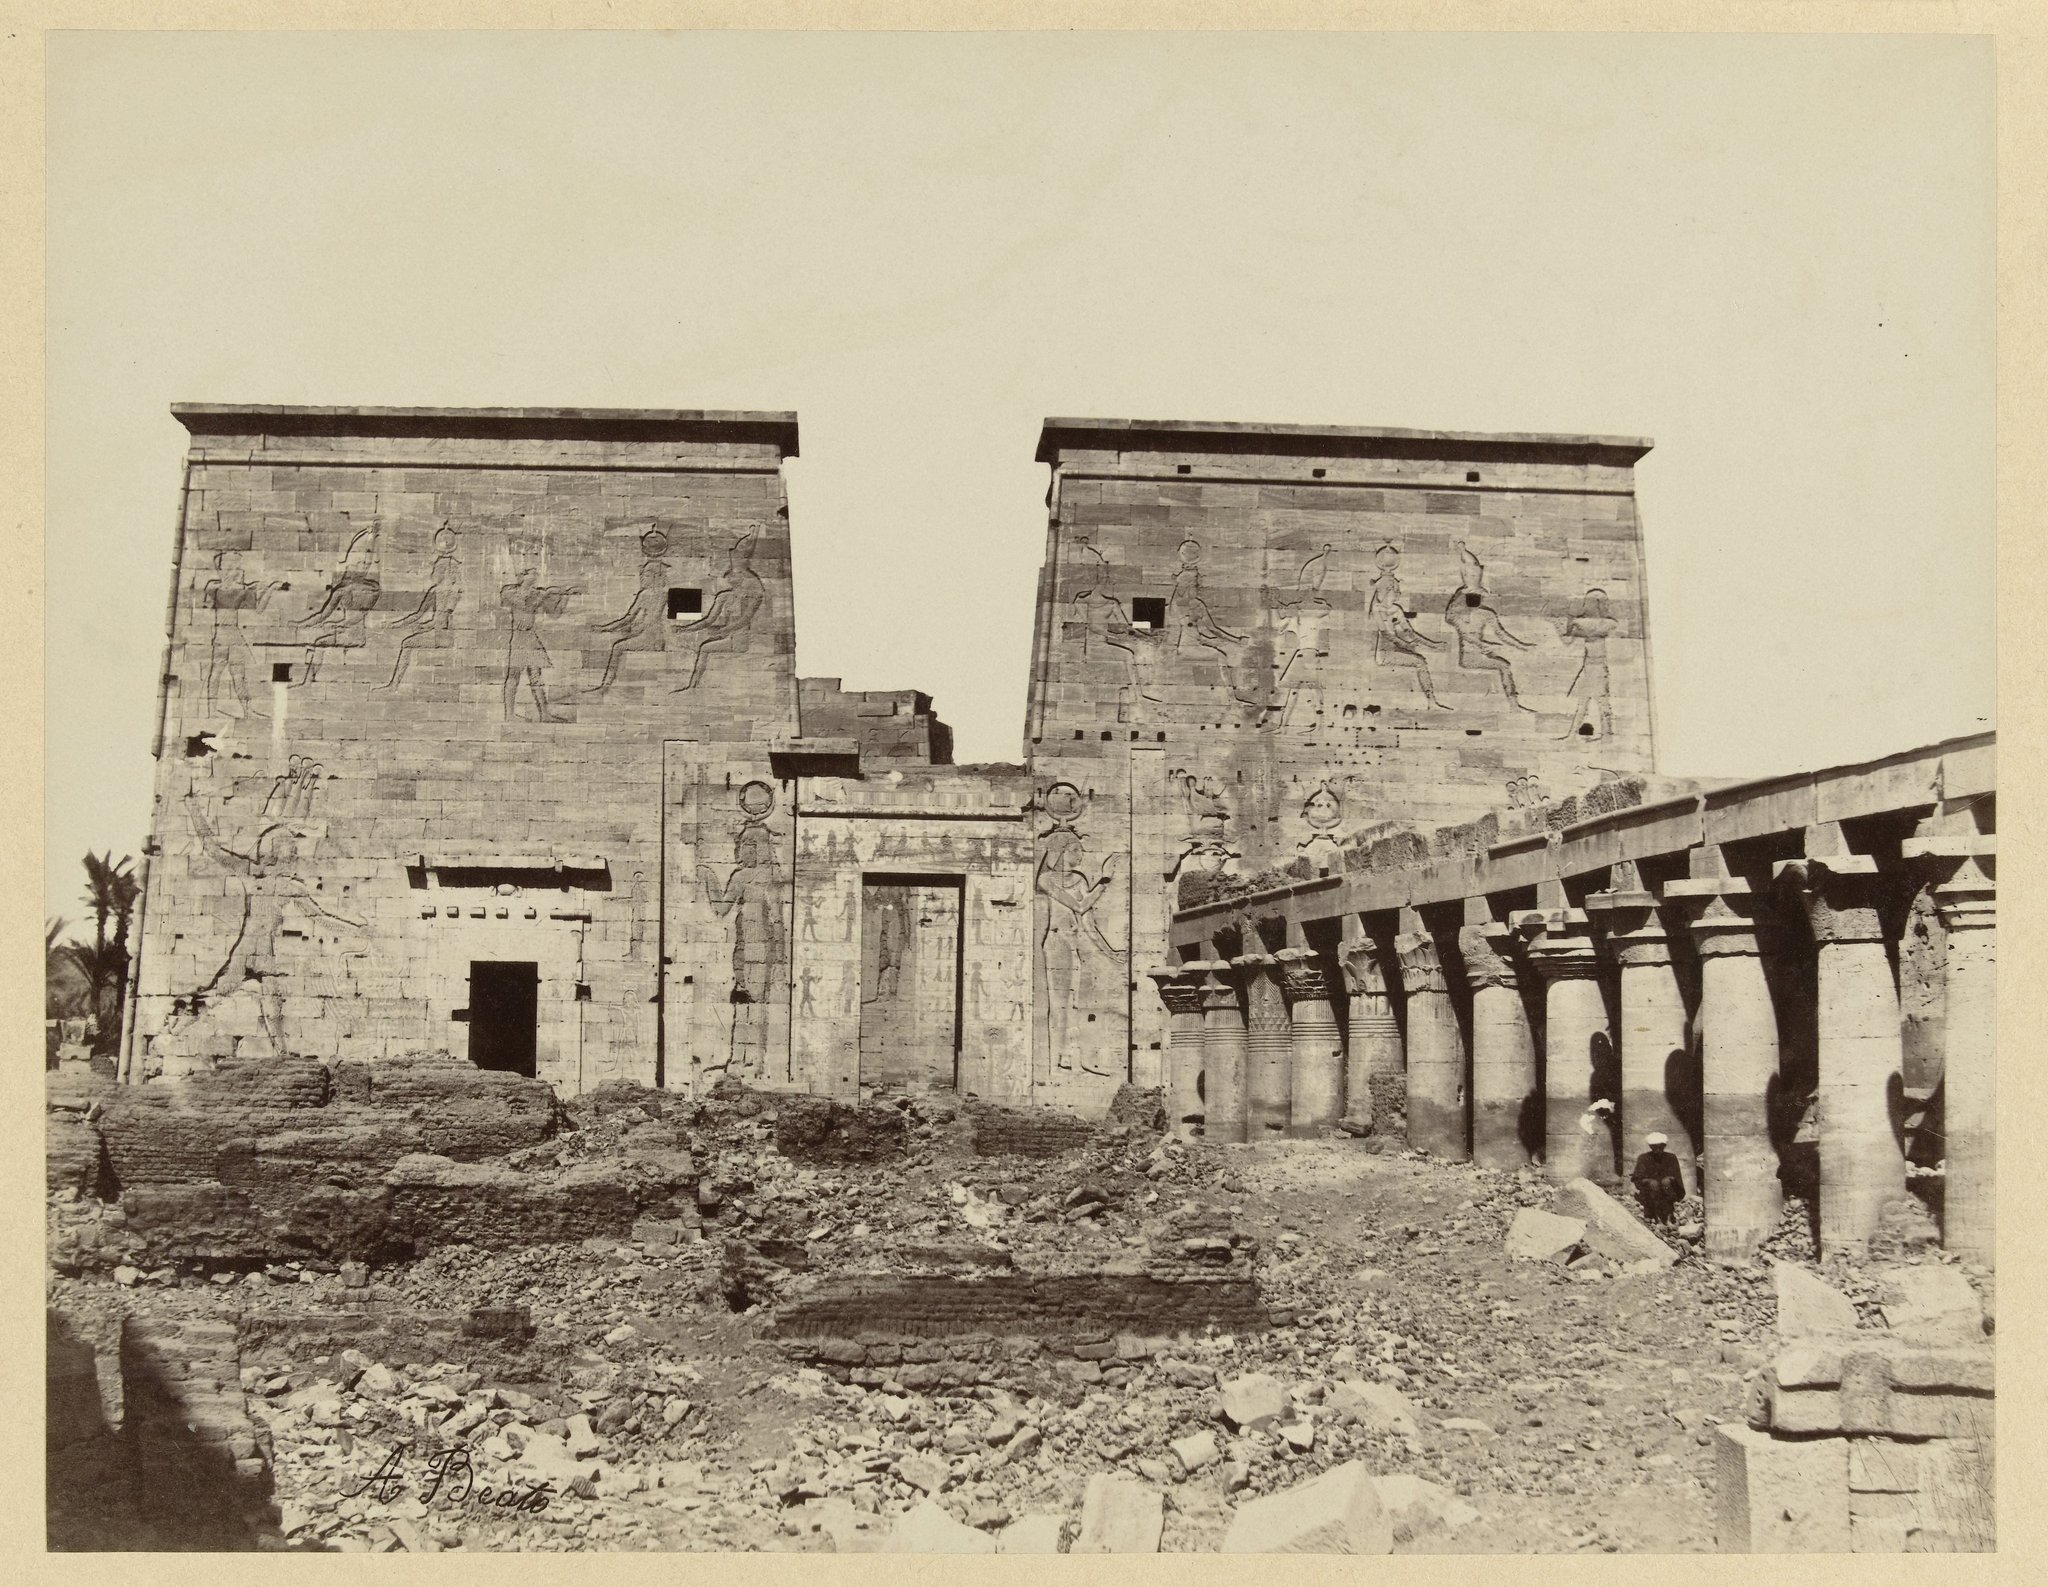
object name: photograph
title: E 113. Zuilen en pylonen van den tempel van Isis. Philae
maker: antonio beato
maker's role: fotograaf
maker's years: 1835-1906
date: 1862-1895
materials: cardboard, paper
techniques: albumen print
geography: philae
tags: temple, shrine ~ egyptian religion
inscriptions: stamp: ‘Gemeentelijke bibliotheek/ Rotterdam’, title: ‘E 113. Zuilen en pylonen van den tempel van Isis. Philae.’, check stamp: ‘Bristol/ L.M.’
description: Onderdeel van een groep door fotograaf Richard Polak op reis verzamelde foto’s. Deze foto is samen met andere op zijn reizen verzamelde foto's tentoongesteld bij de Rotterdamsche Kunstkring (1895), Arti en Amicitiae te Amsterdam (1897-1898?) en Societeit 't Collegie te Kampen (datum vooralsnog onbekend).